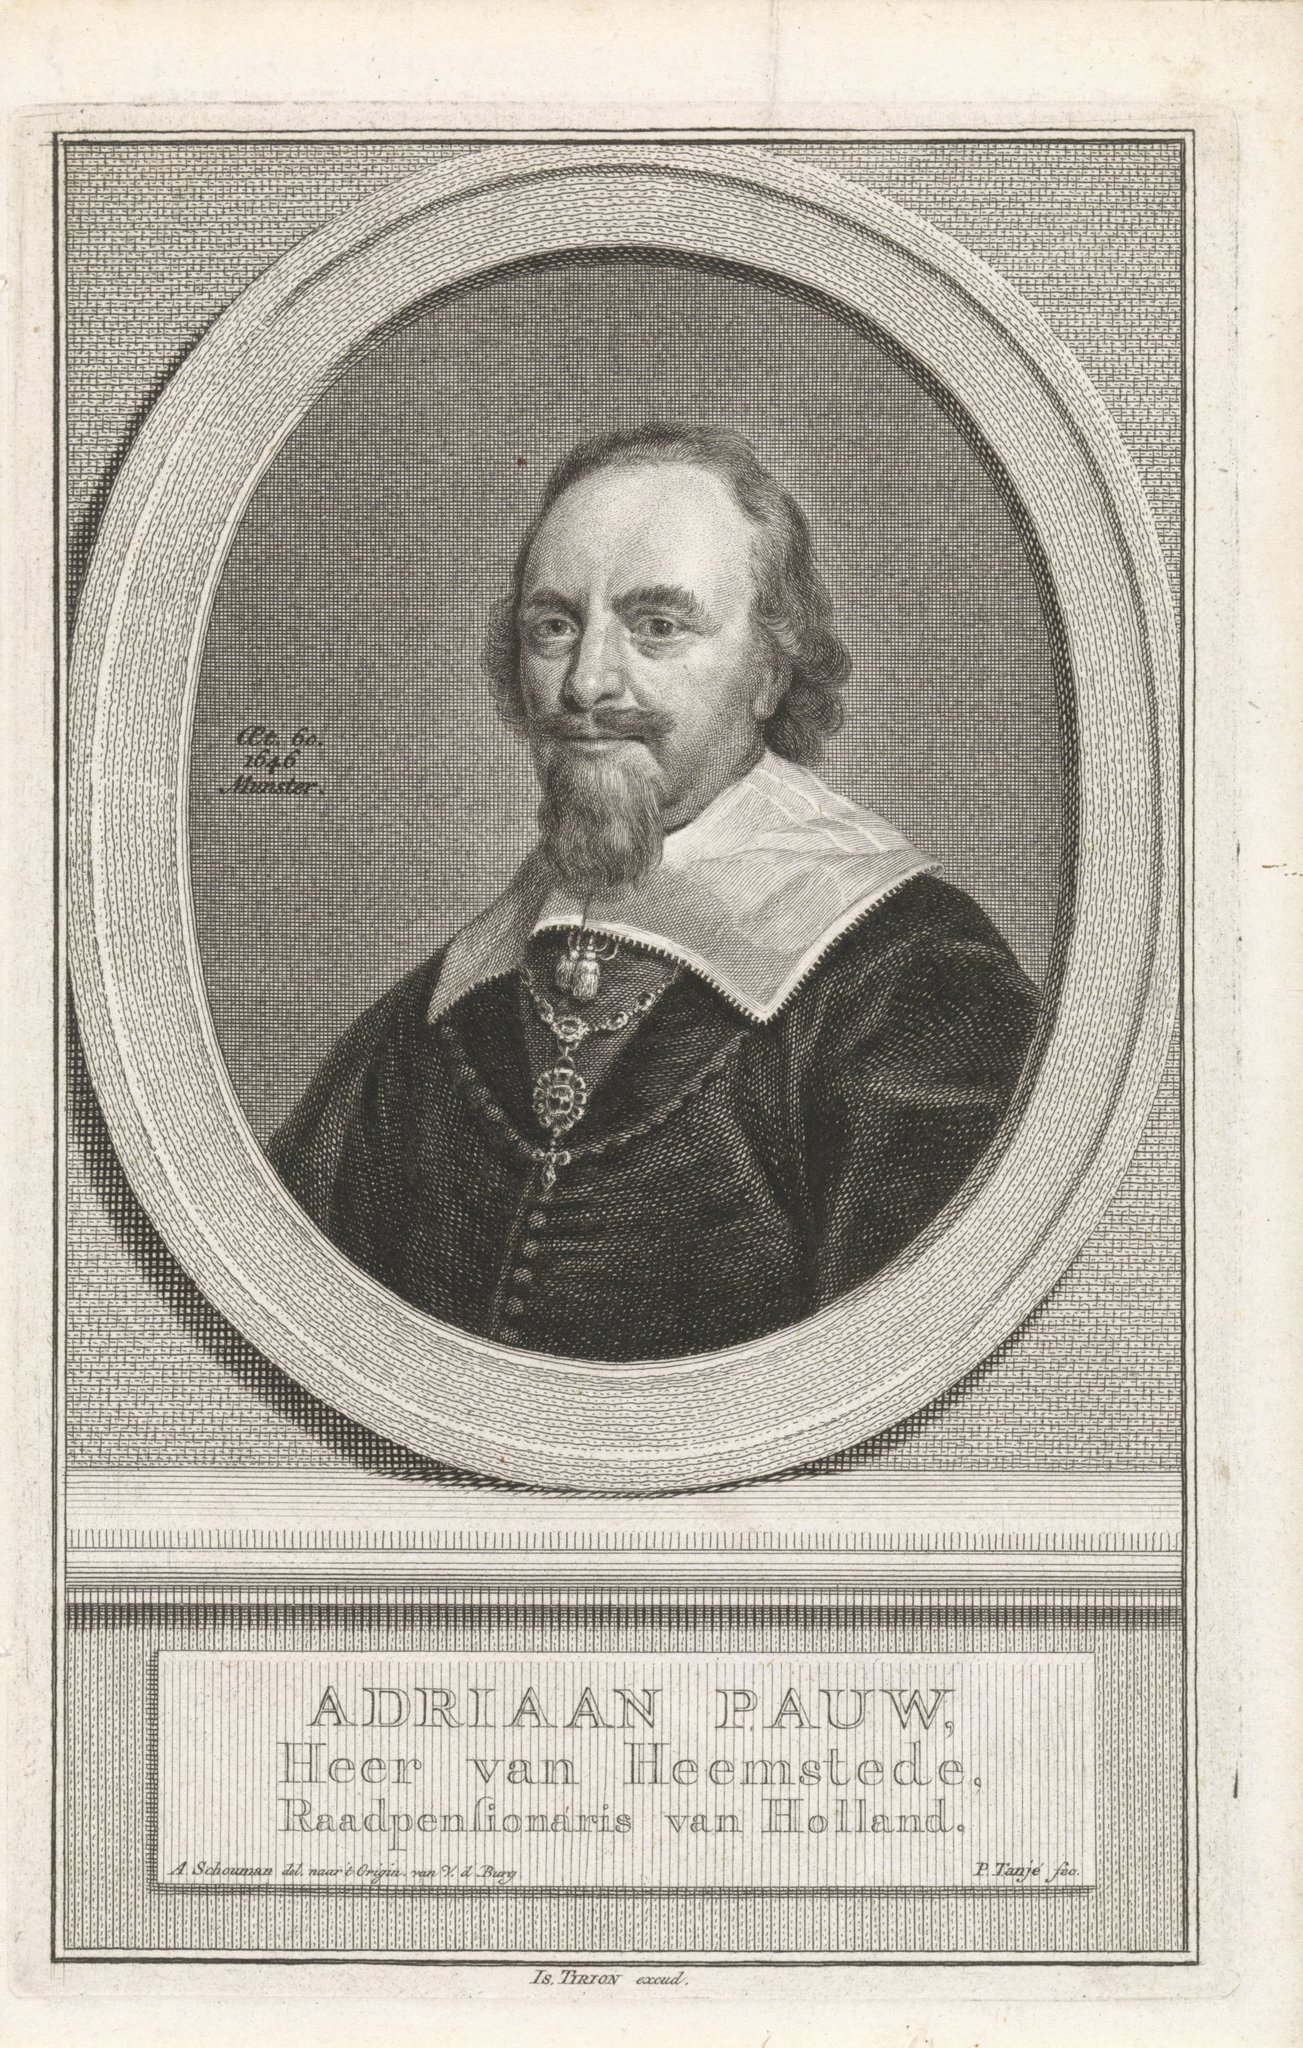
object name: print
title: Portret van Adriaen Pauw op 60-jarige leeftijd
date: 1716-1761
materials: paper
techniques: engraving, etching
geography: amsterdam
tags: the hague, politician, adriaen pauw (1585-1653), historical persons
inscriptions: collector's mark: Lugt 2228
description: Adriaen Pauw, heer van Heemstede en raadspensionaris van Holland, op 60-jarige leeftijd.